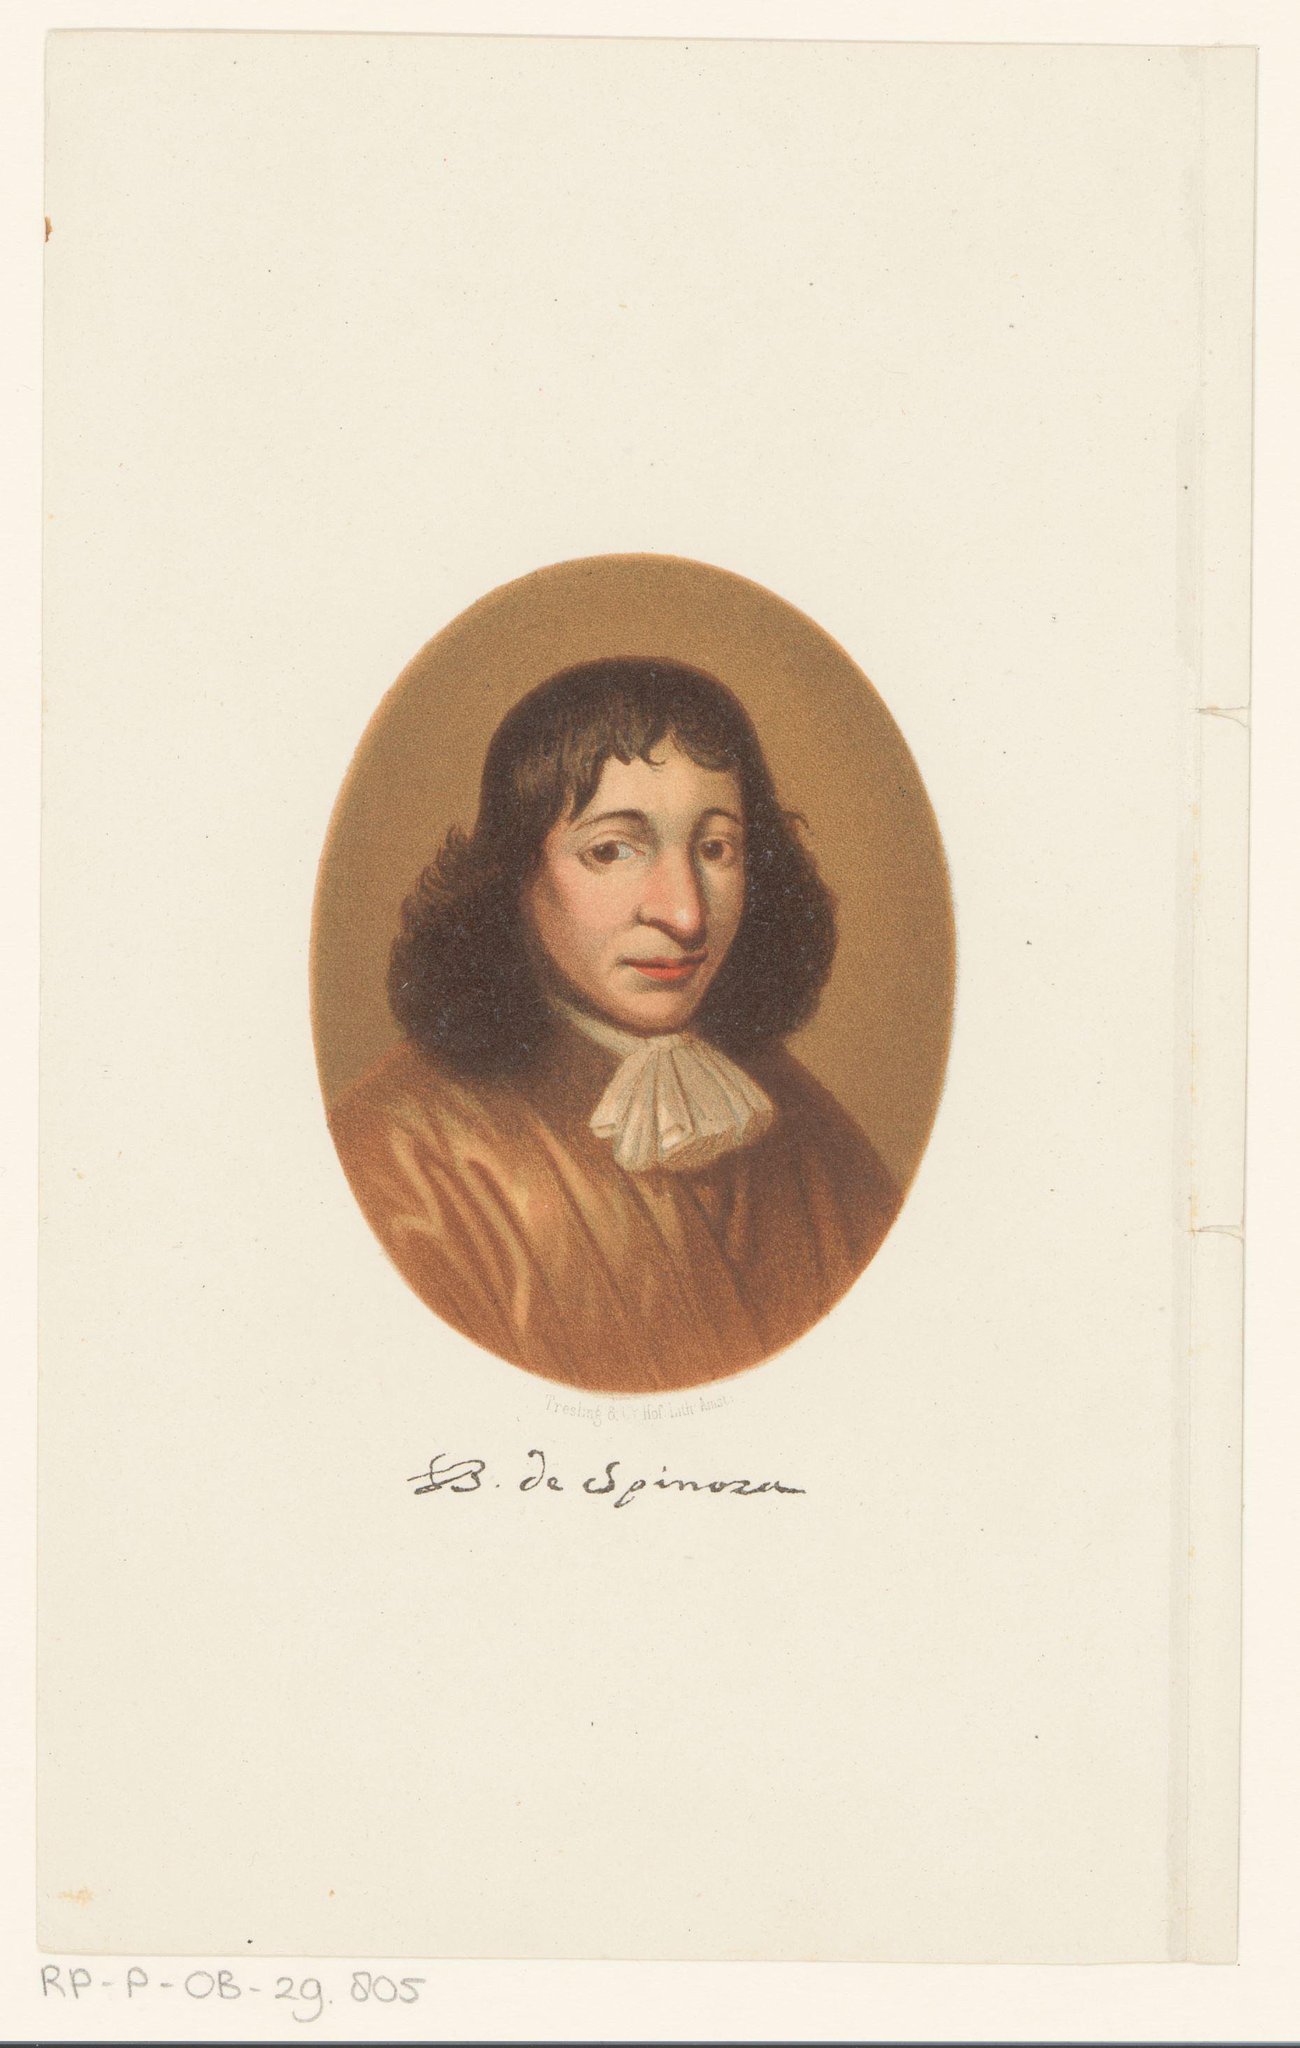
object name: print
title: Portret van Baruch de Spinoza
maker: Anonymous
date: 1858-1919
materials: paper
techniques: lithograph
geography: amsterdam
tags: amsterdam, the hague, baruch de spinoza, historical persons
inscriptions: collector's mark: Lugt 2228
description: Onder het portret de signatuur van de geportretteerde.